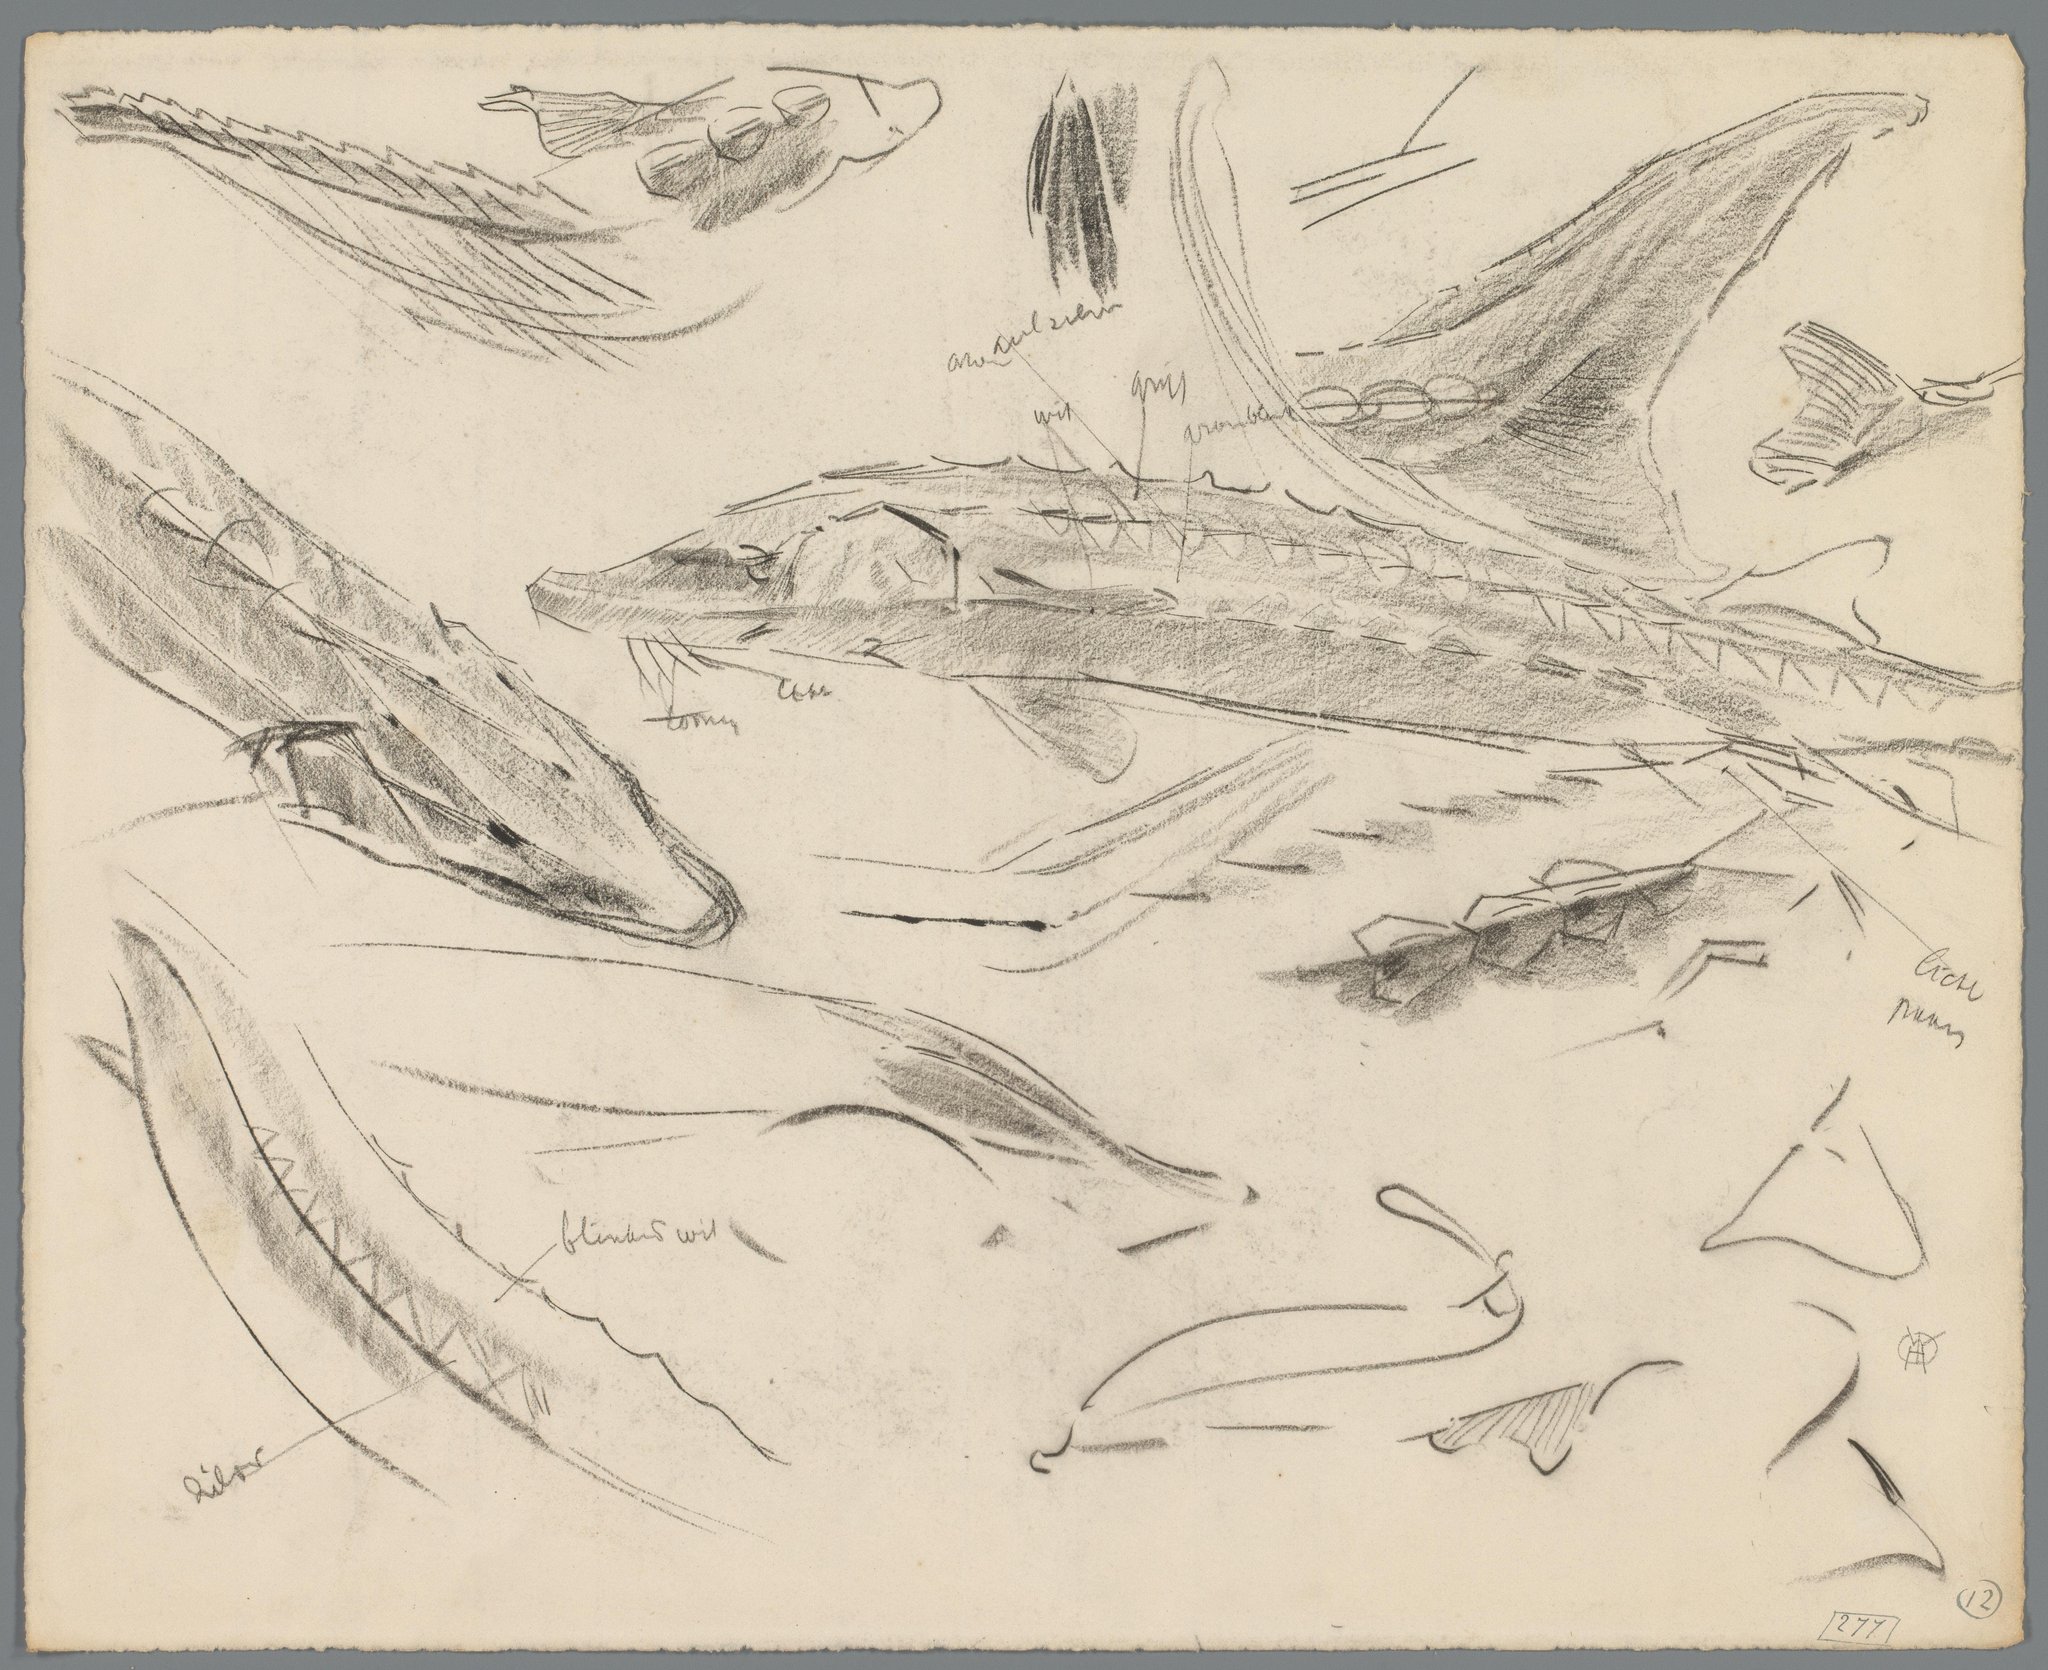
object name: drawing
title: Studies van een steur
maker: gerrit willem dijsselhof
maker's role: designer, draughtsman, print maker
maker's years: 1866-1924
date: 1876-1924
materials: chalk, paper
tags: bony fishes: sturgeon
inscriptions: number: ‘277’, number: ‘12’